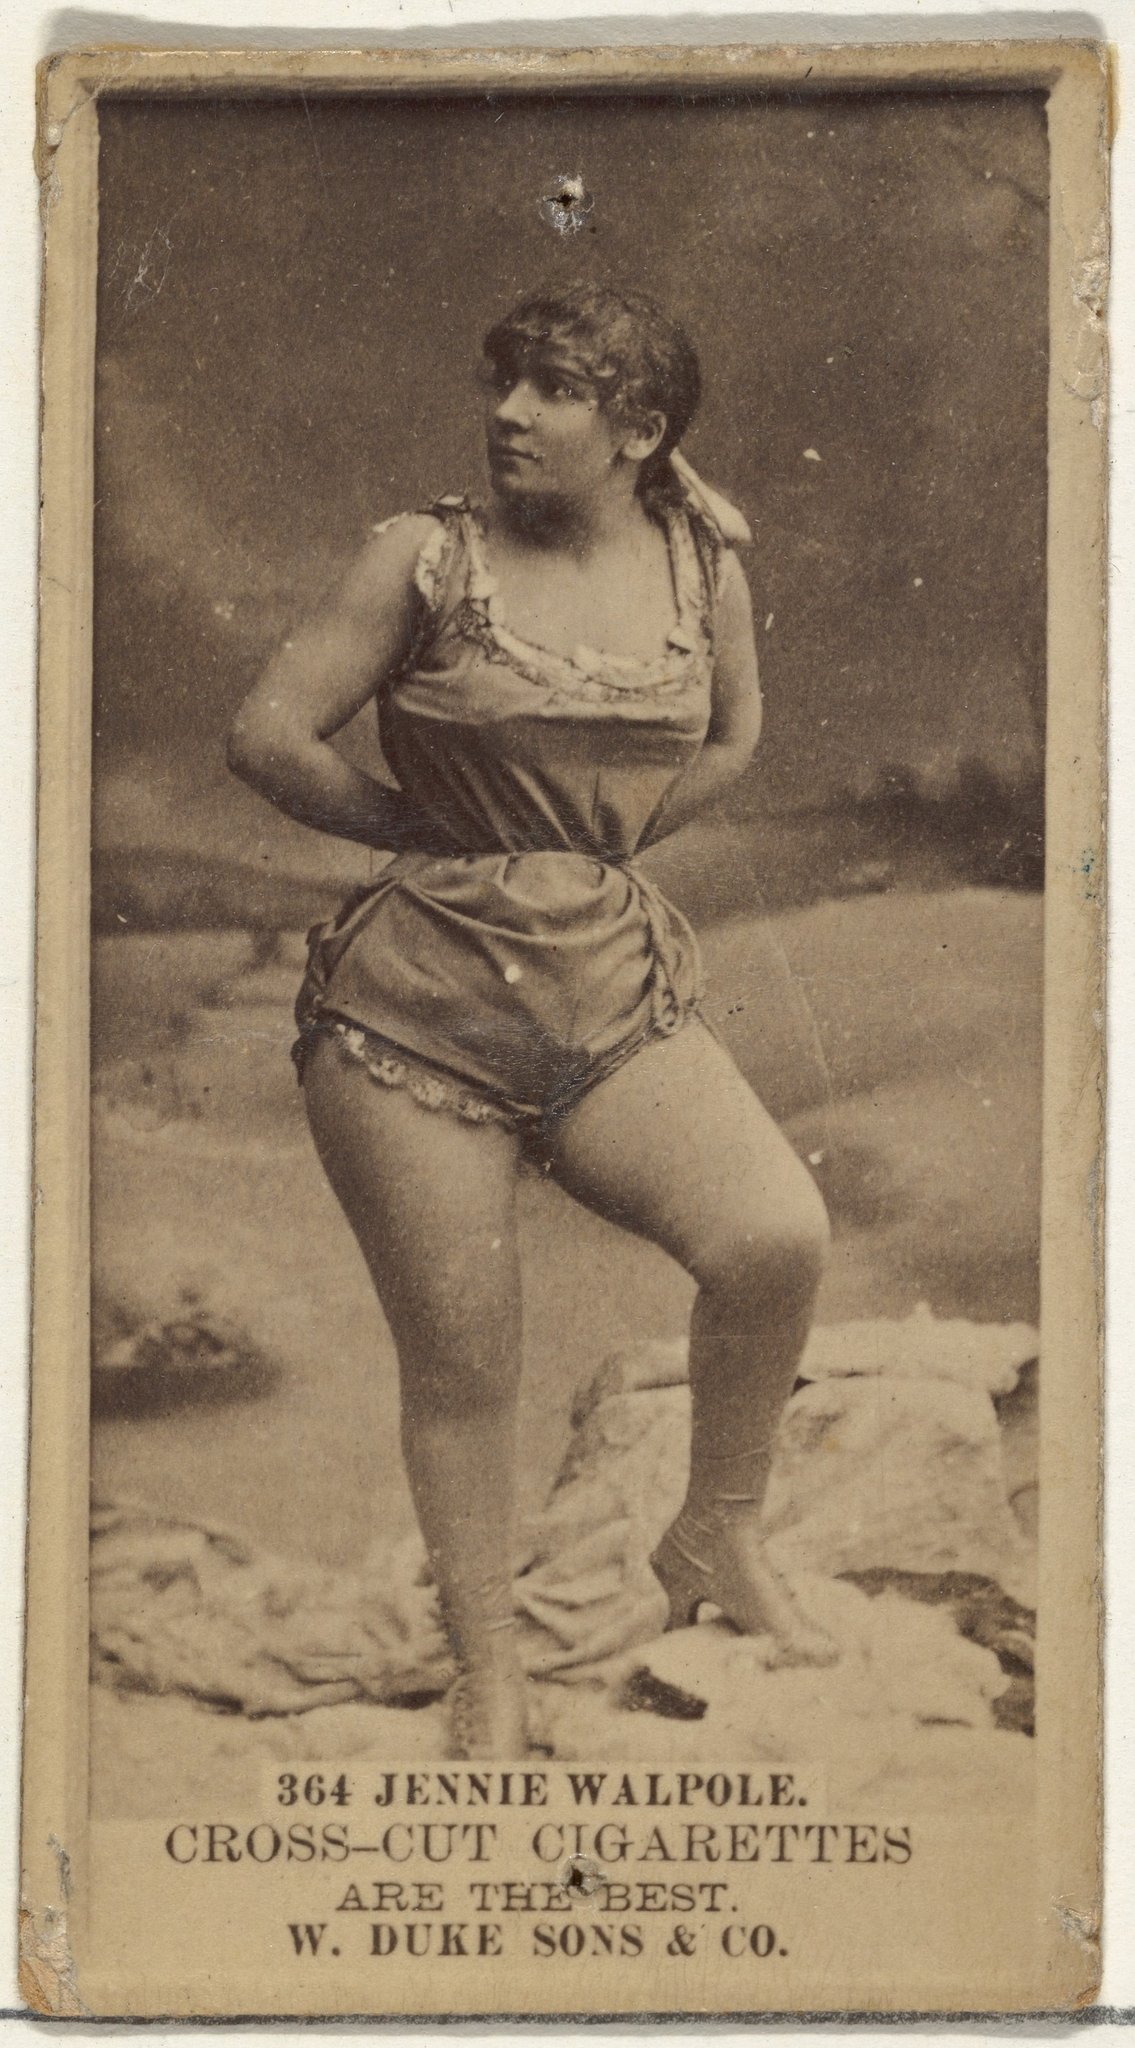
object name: photograph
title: Card Number 364, Jennie Walpole, from the Actors and Actresses series (N145-3) issued by Duke Sons & Co. to promote Cross Cut Cigarettes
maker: w. duke, sons & co.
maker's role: publisher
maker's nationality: american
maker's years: 1870-1920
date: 1880-1889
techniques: albumen silver print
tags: portraits,women,actresses